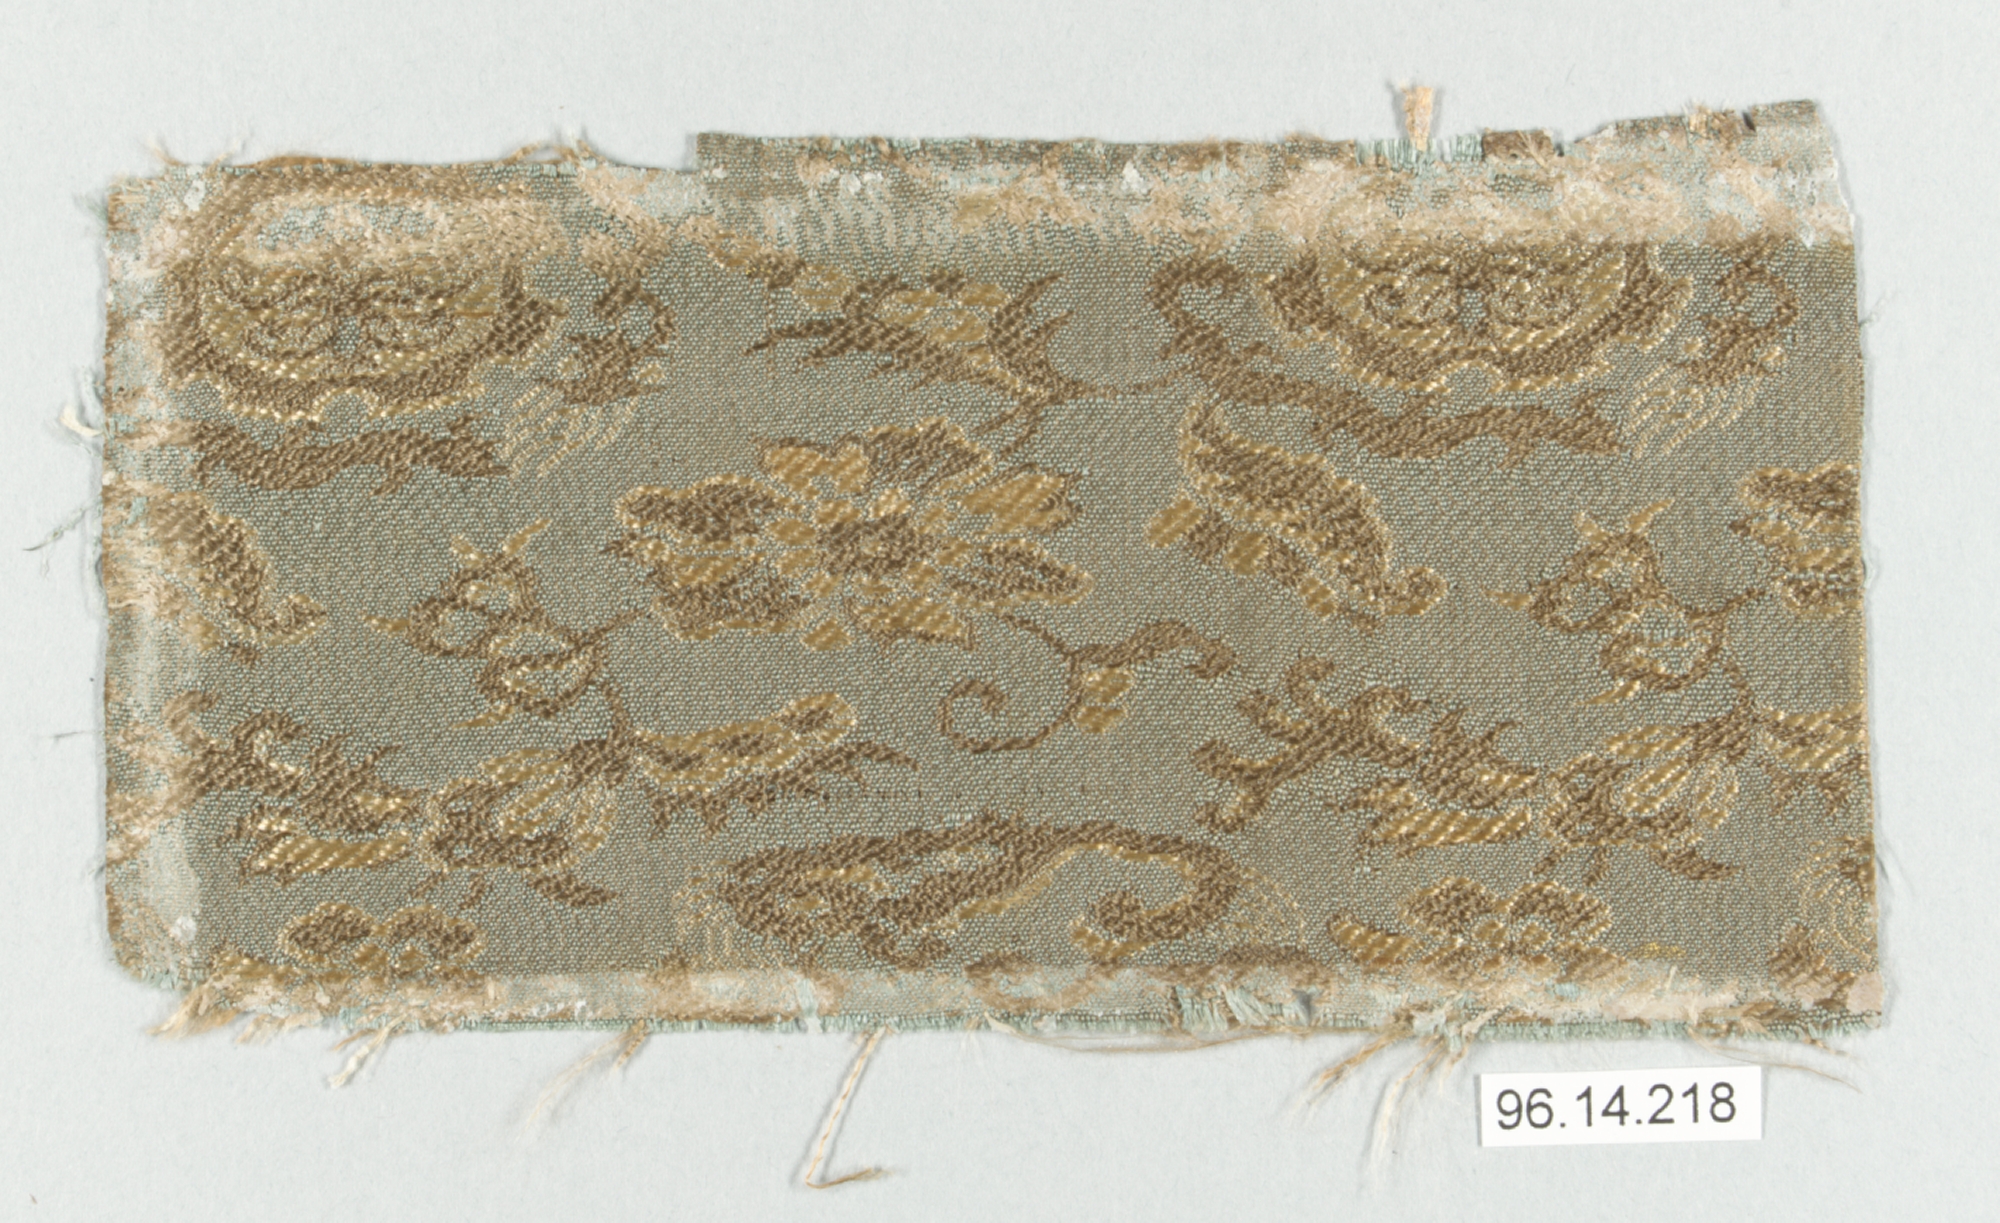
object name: piece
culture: japanese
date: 1801-1900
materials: silk